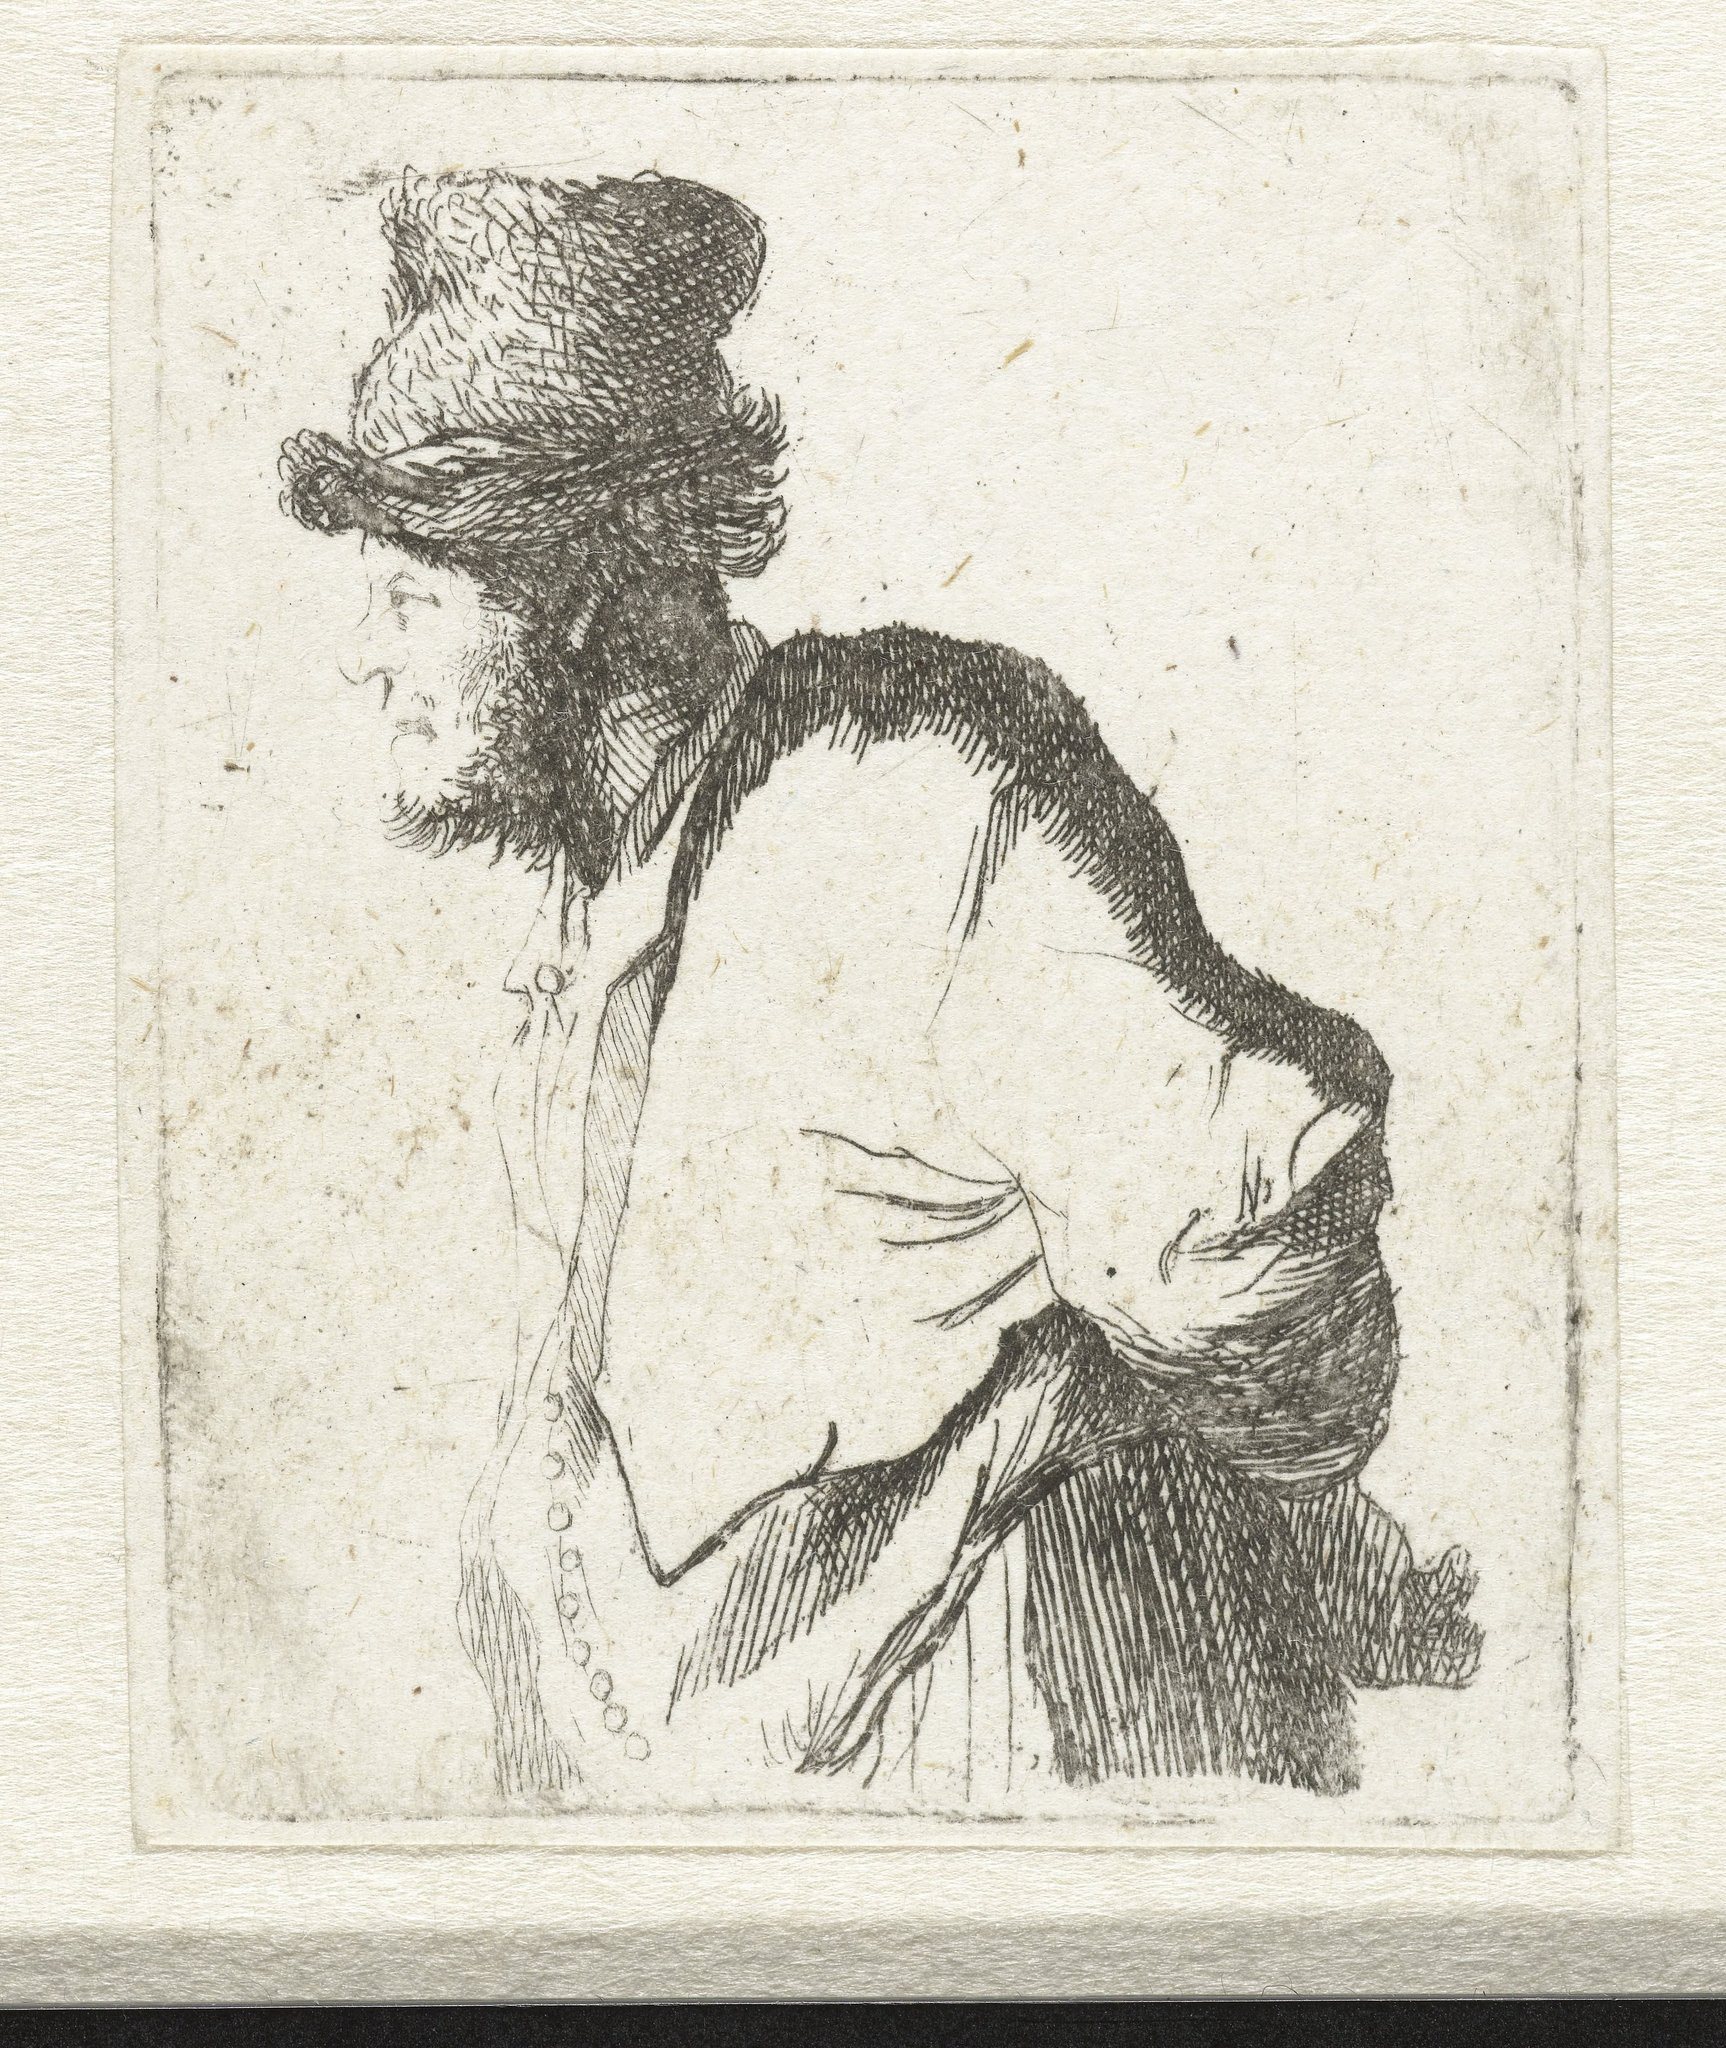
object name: print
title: Peasant with his hands behind his back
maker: Anonymous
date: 1631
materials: paper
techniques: etching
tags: adult man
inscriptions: collector's mark: Lugt 2228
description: Spiegelbeeldige kopie naar de gelijknamige prent van Rembrandt.